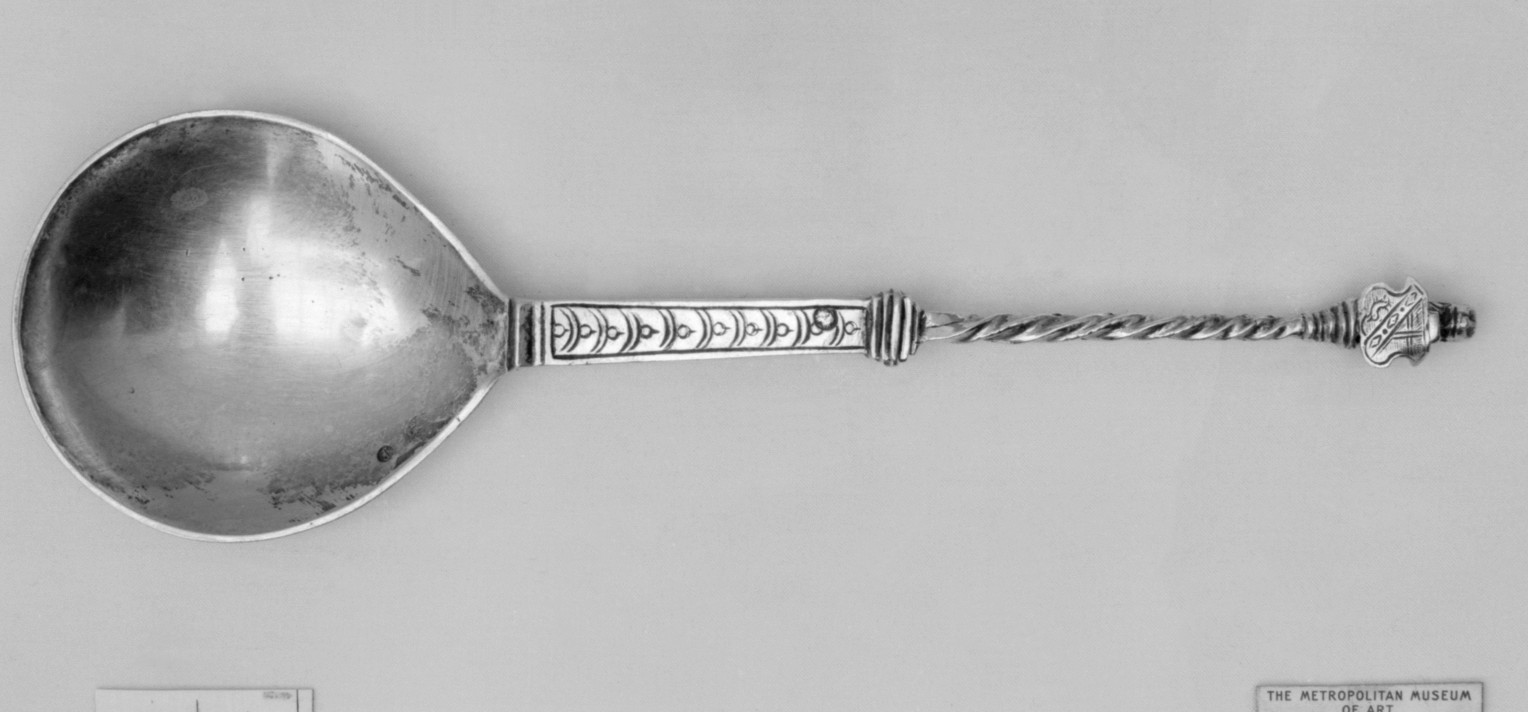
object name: spoon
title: Figure-top spoon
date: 1890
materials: silver